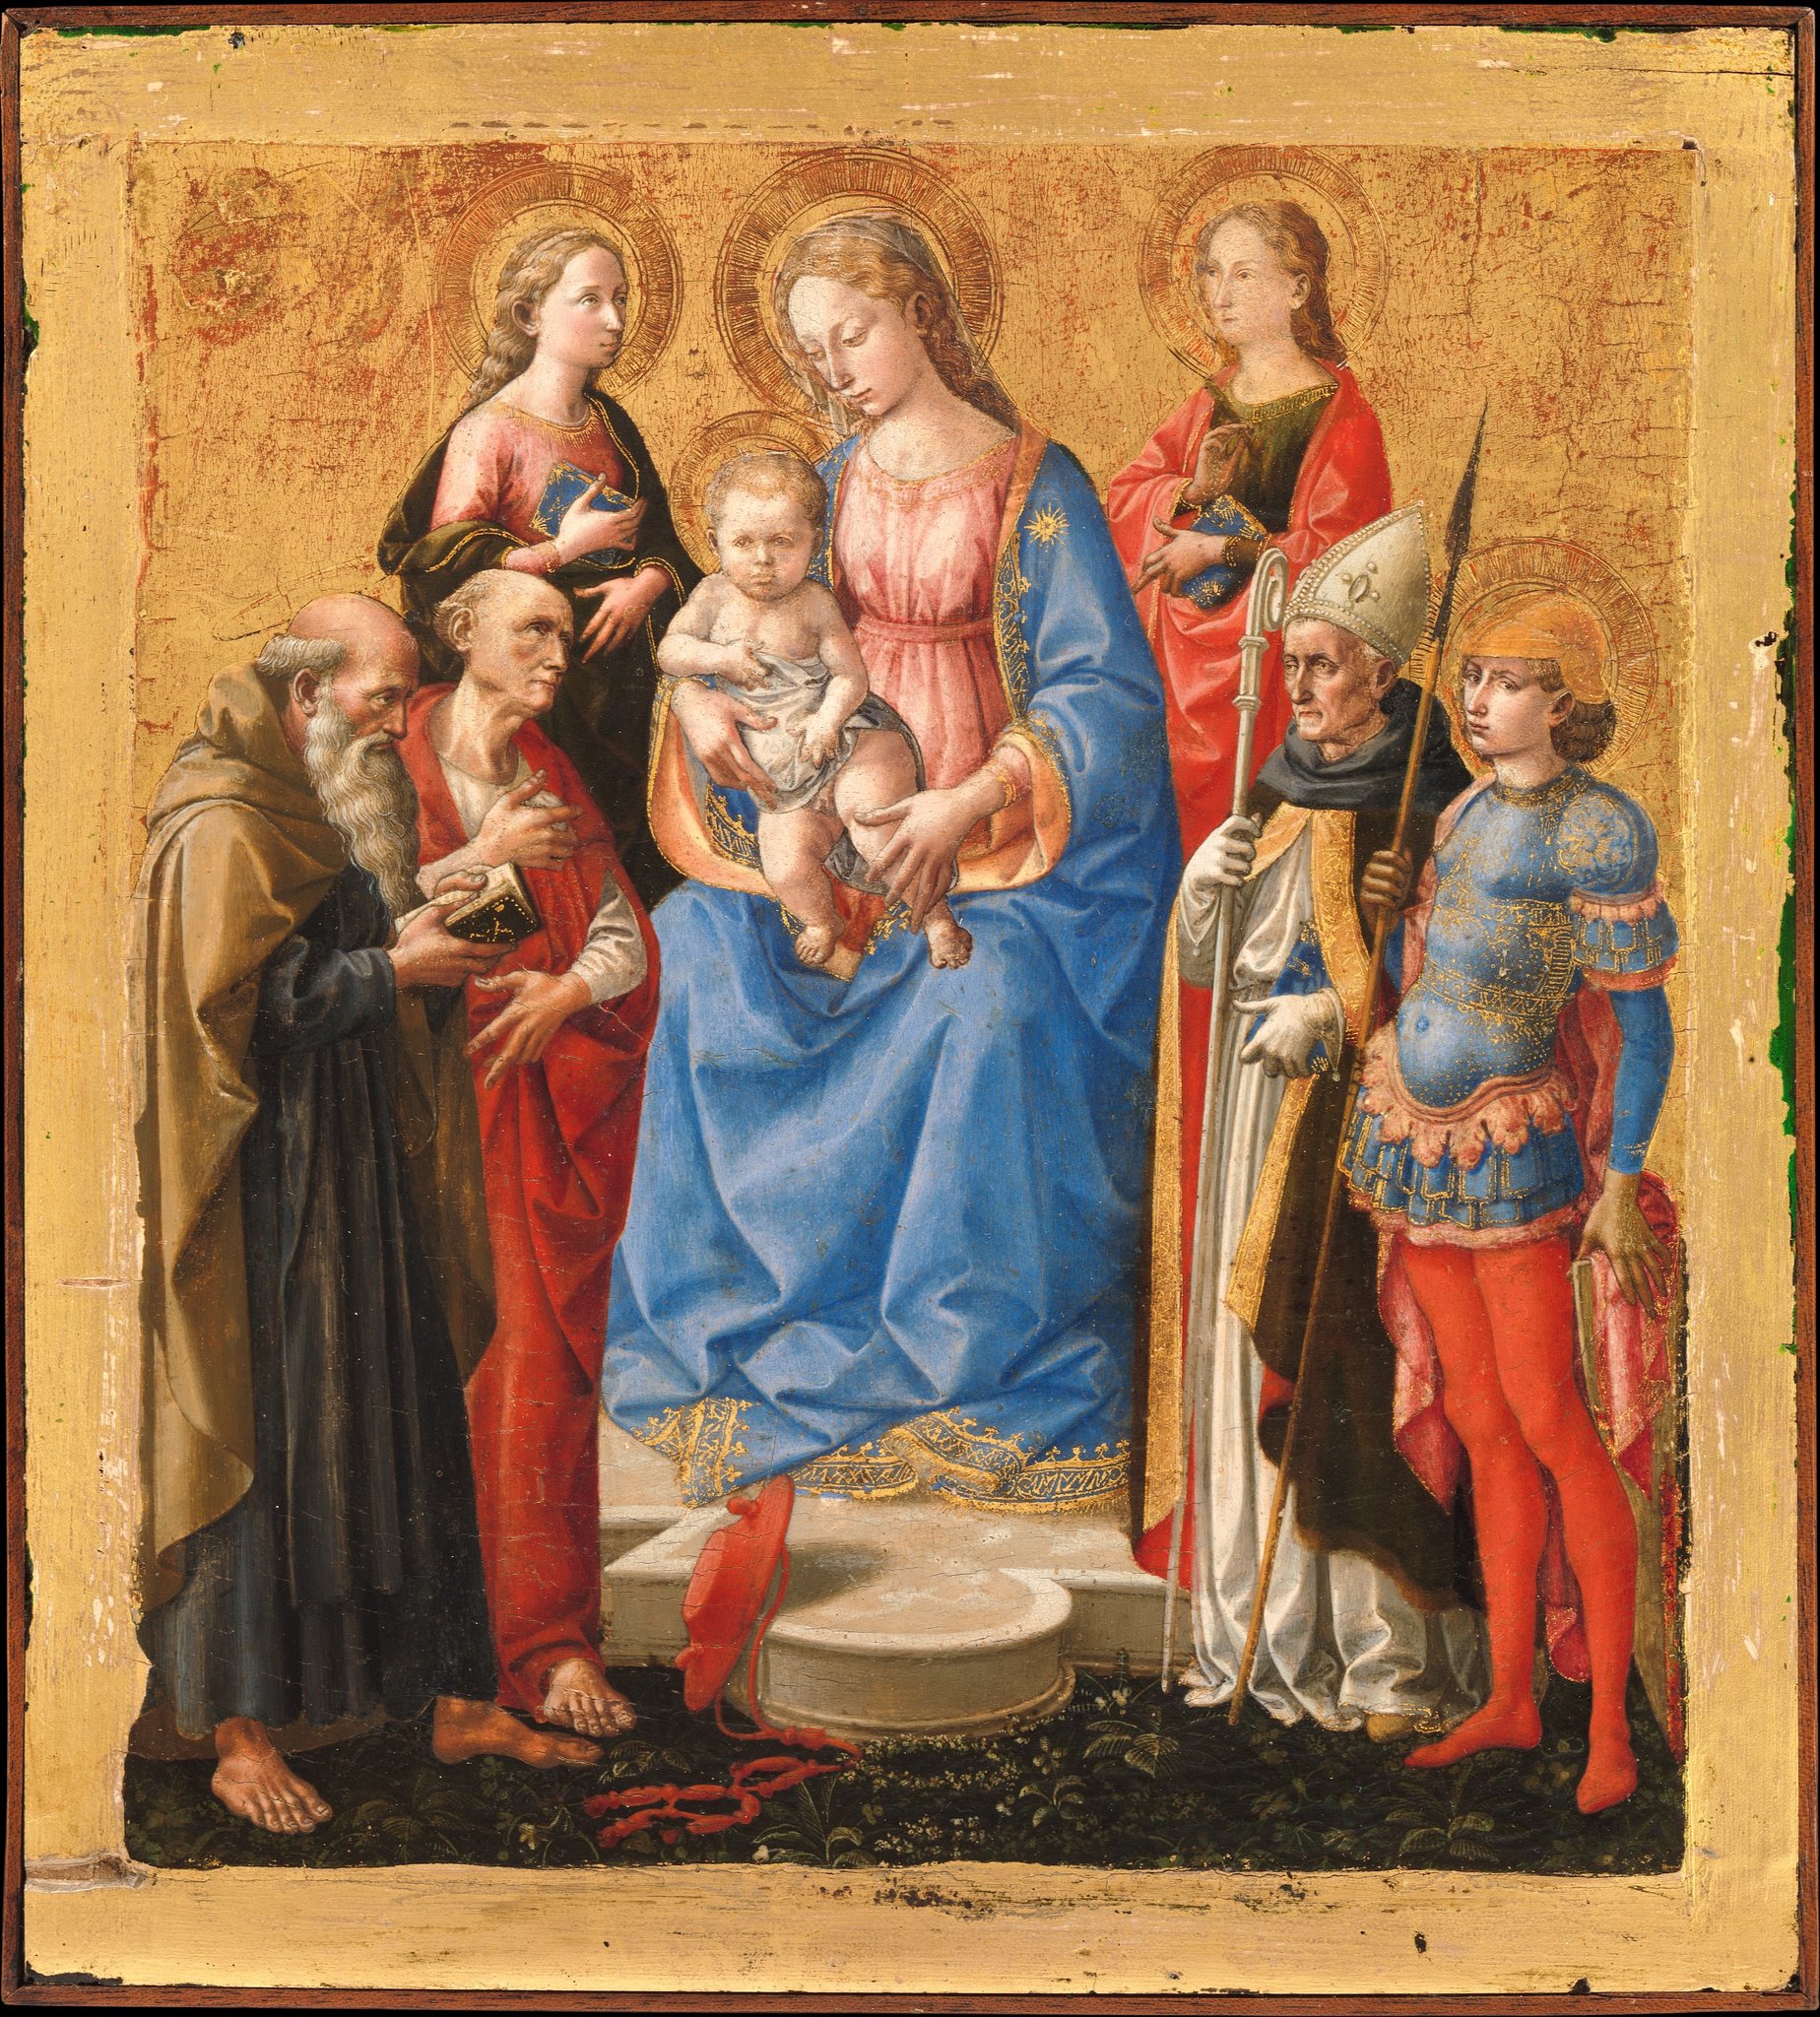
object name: painting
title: Madonna and Child with Six Saints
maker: pesellino (francesco di stefano)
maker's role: artist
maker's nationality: italian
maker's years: 1422-1457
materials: gold leaf, paint, wood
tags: men,women,madonna and child,saint catherine,saint george,saint jerome